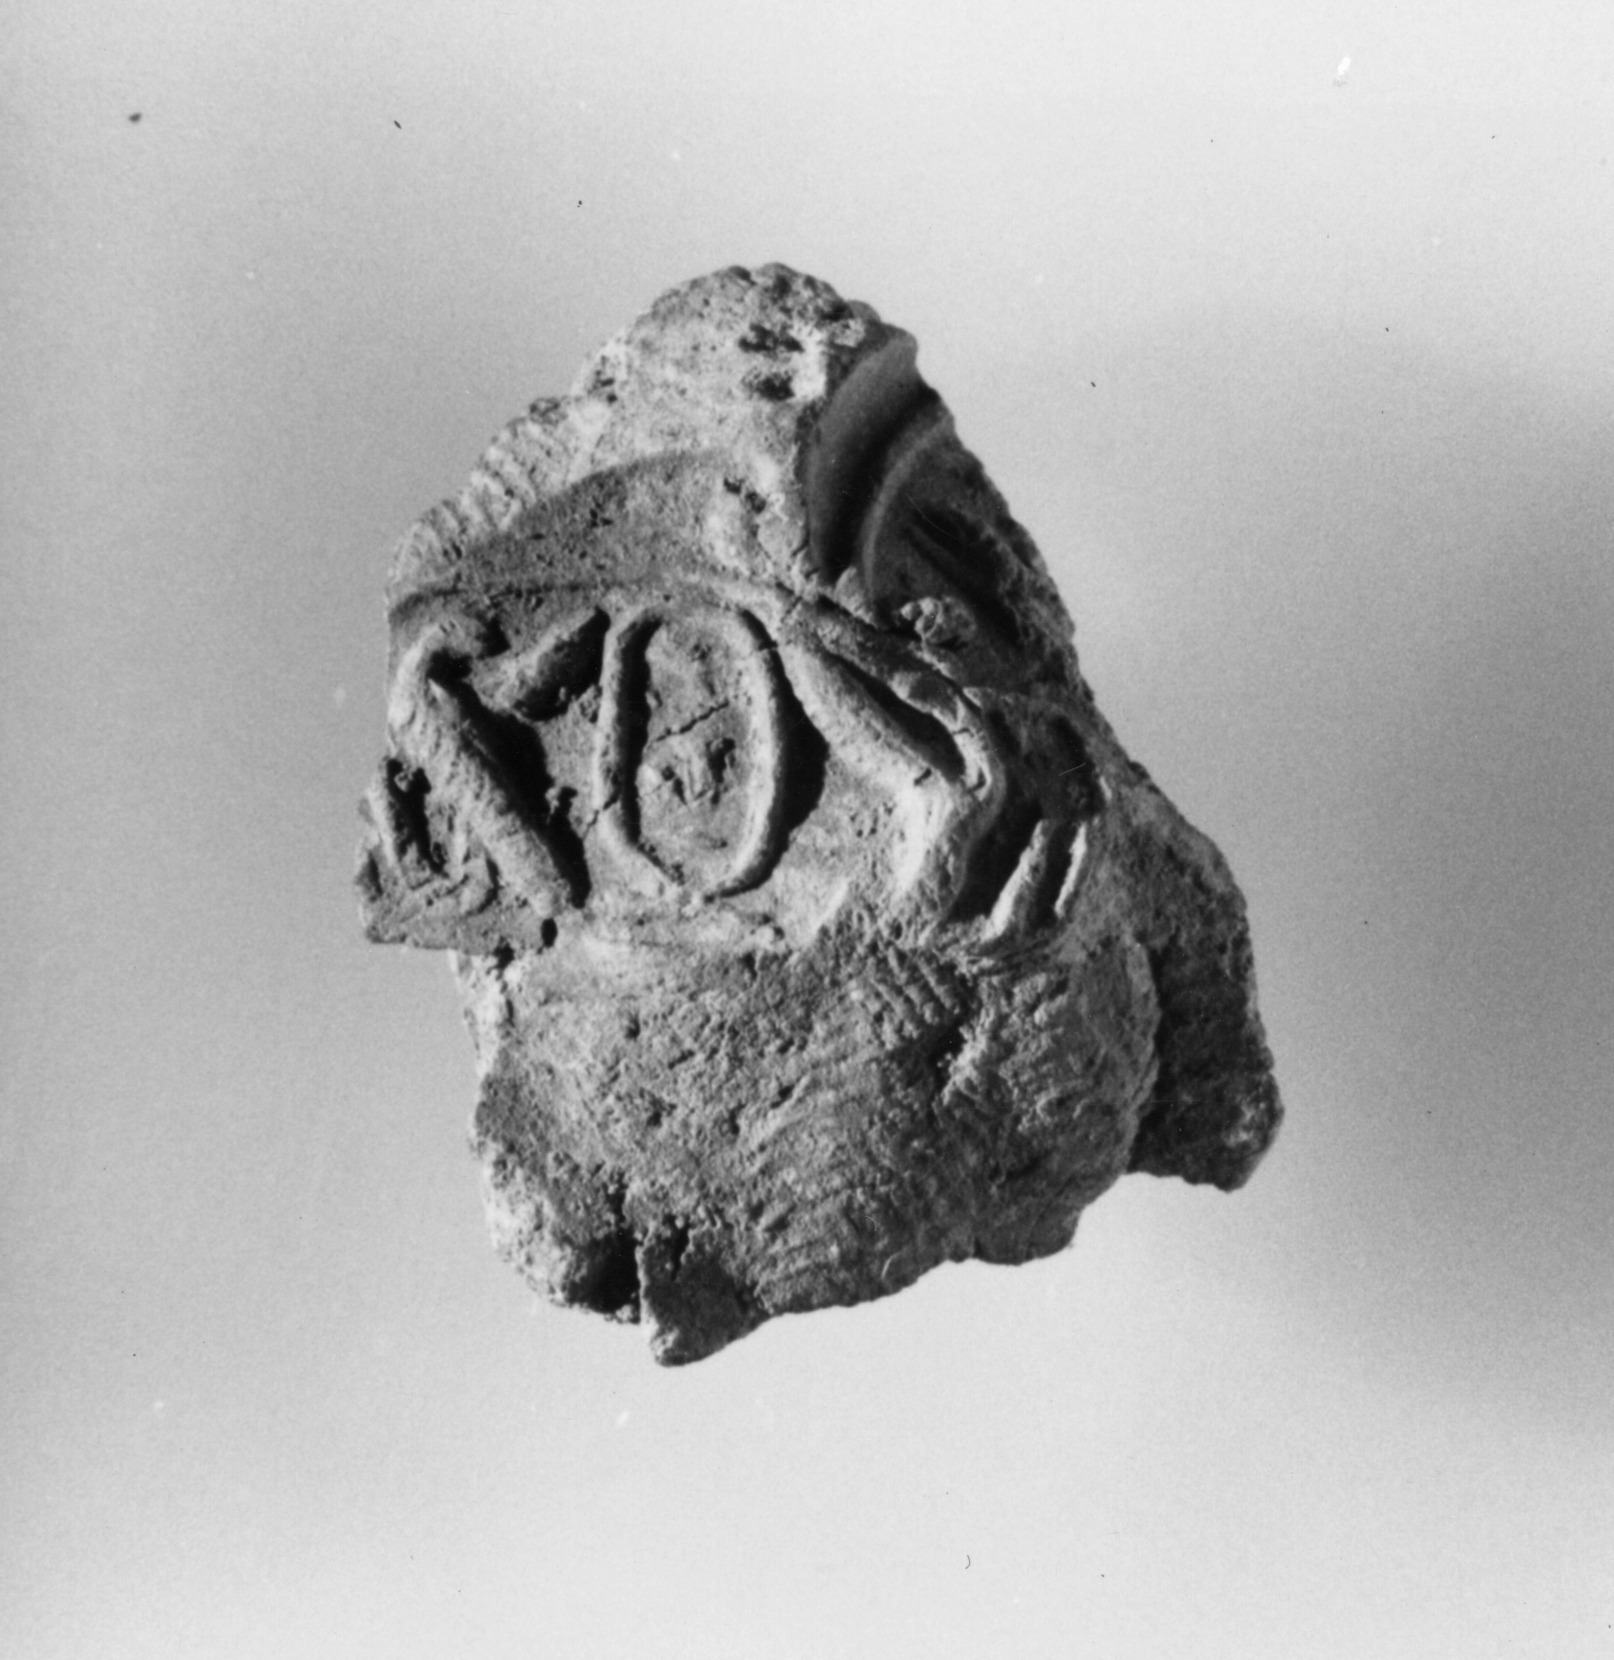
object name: sealing, amenhotep iii, nebmaatre, cobra,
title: Document Sealing With Multiple Seal Impressions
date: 1390-1352 BCE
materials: mud